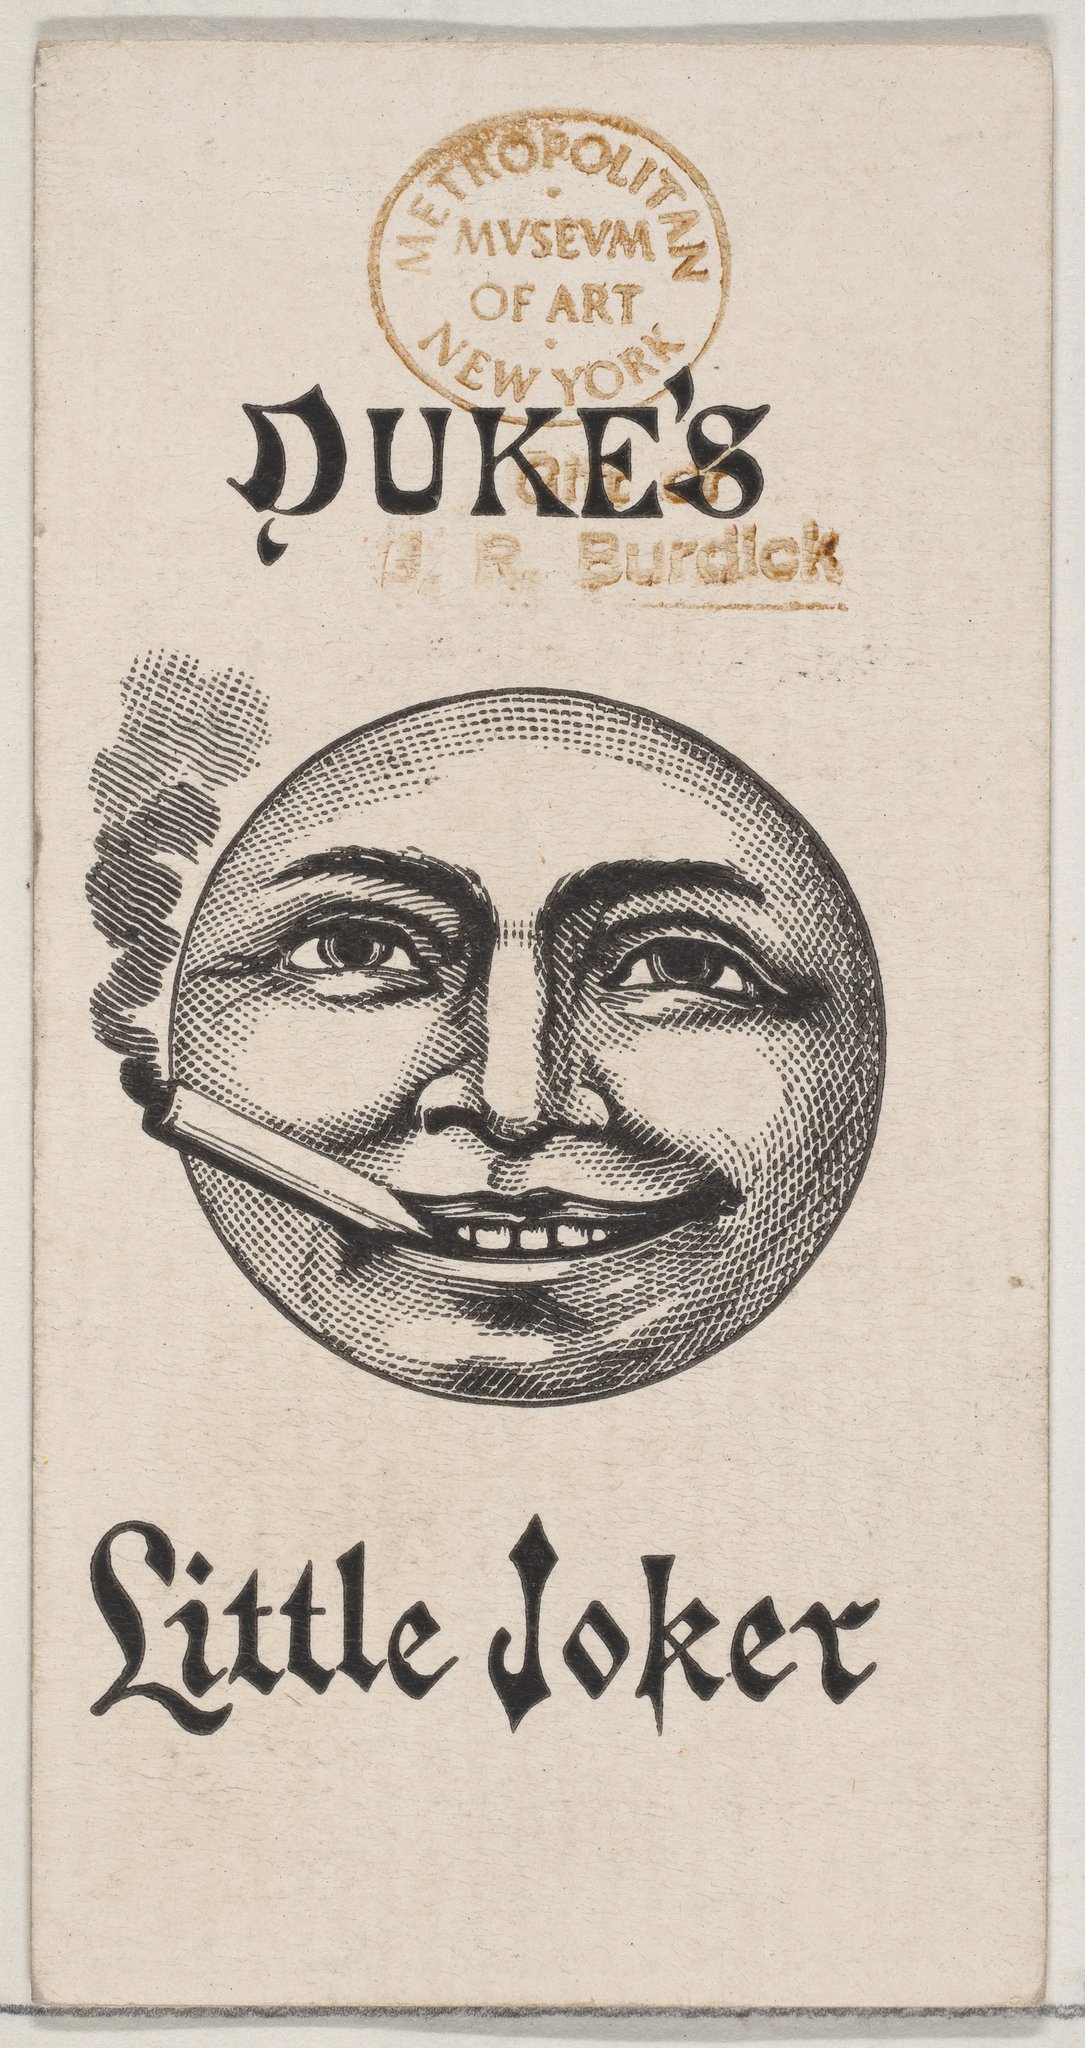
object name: print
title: Duke's Little Joker, from the Playing Cards series (N84) for Duke brand cigarettes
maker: w. duke, sons & co.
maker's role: publisher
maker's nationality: american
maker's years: 1870-1920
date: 1888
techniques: color lithograph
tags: playing cards